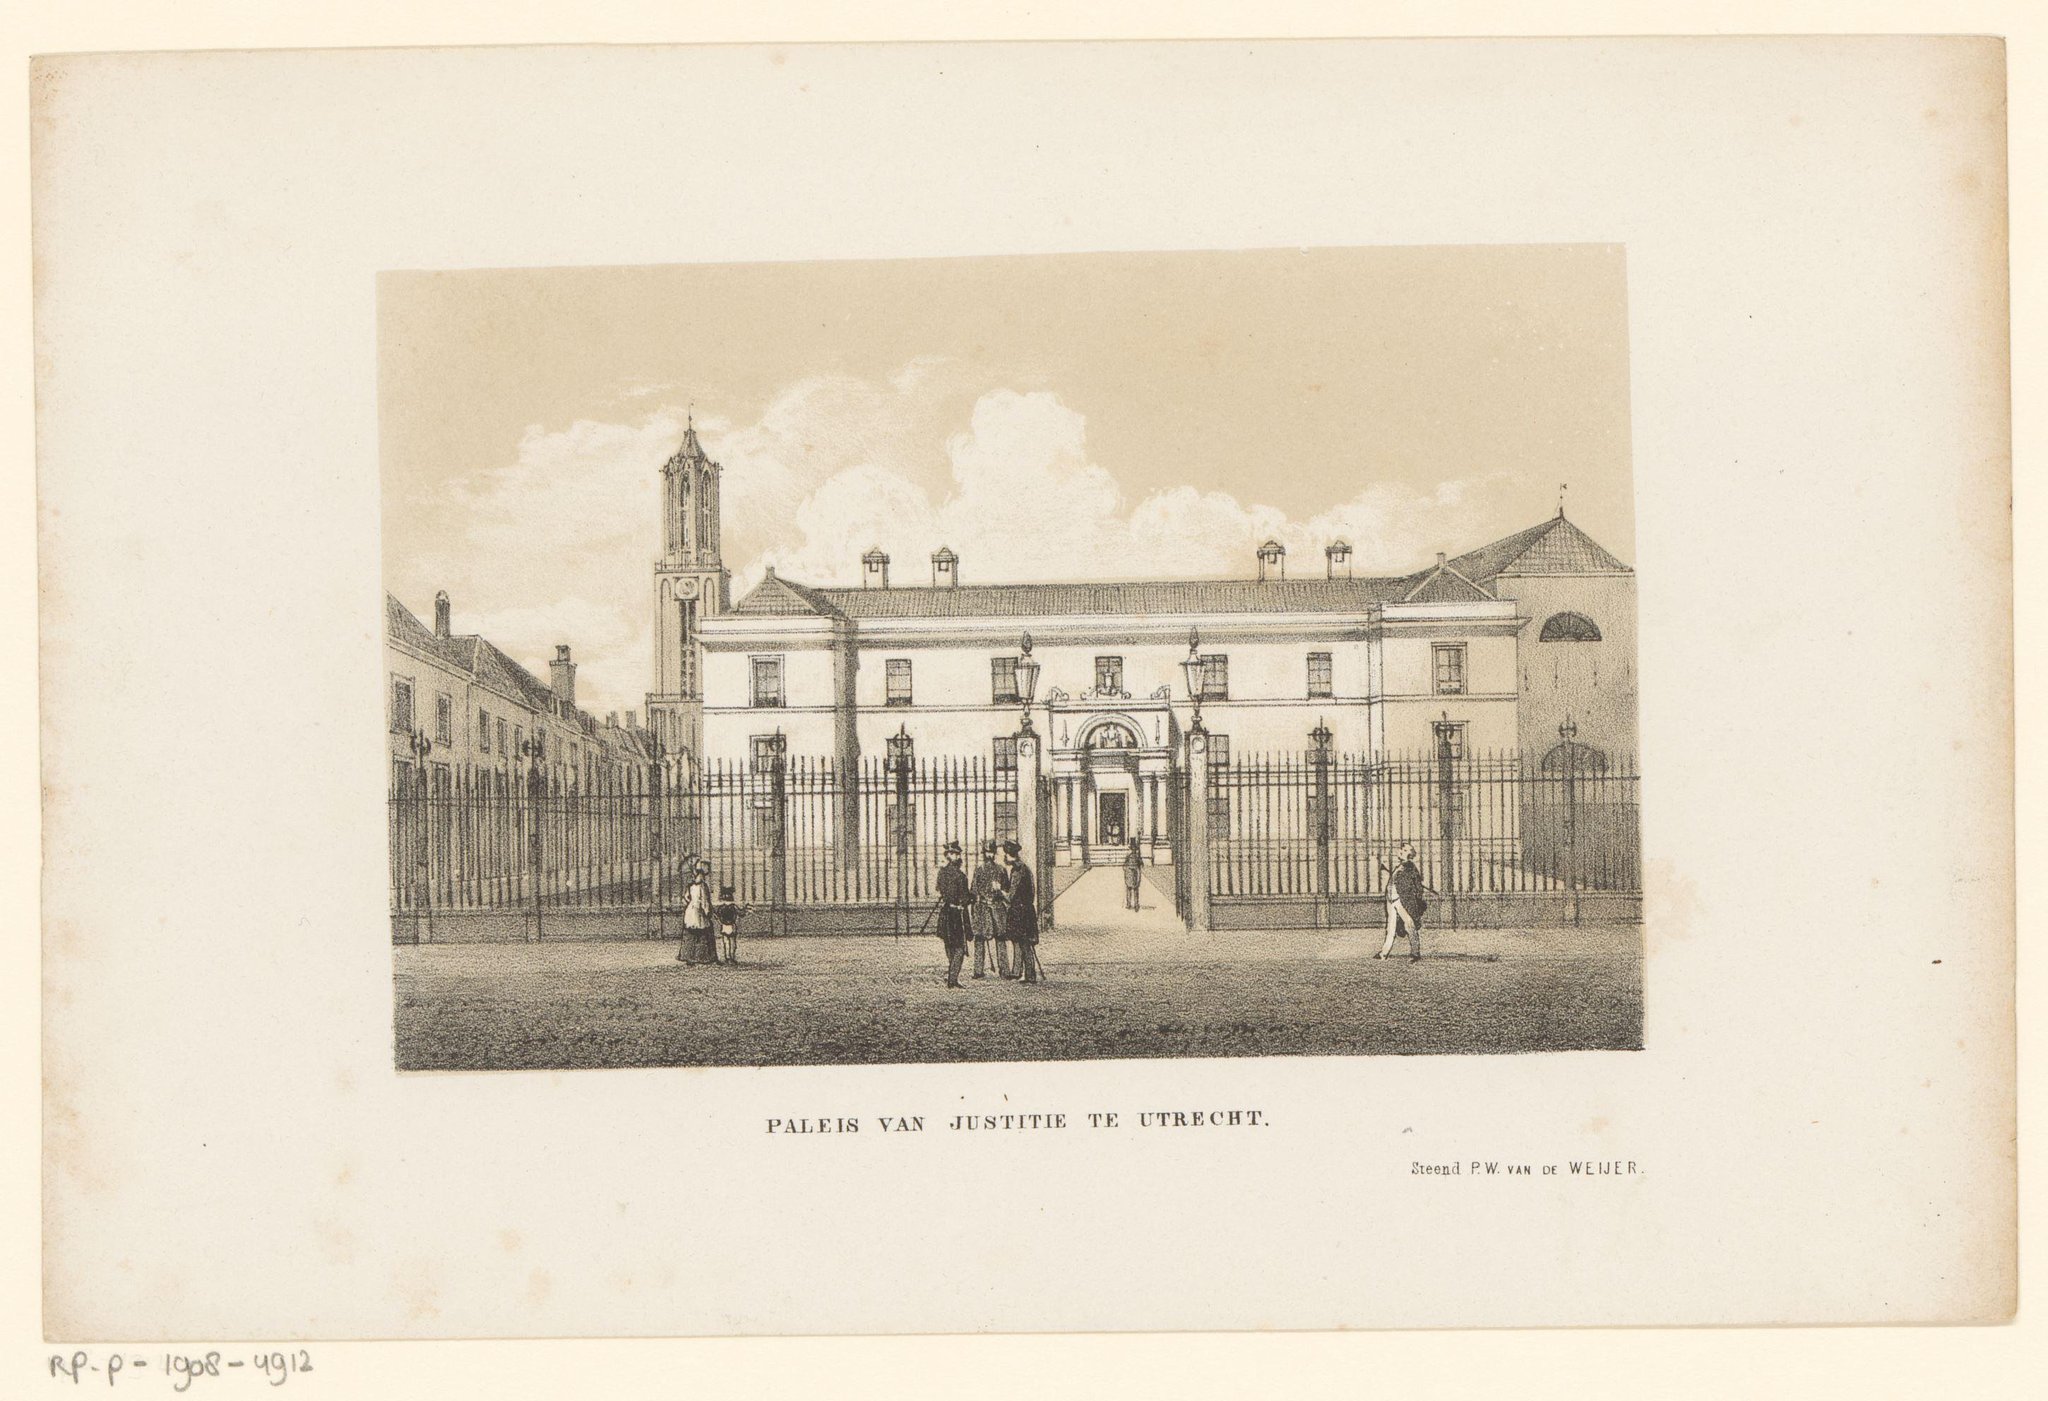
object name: print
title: Paleis van Justitie te Utrecht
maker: pieter wilhelmus van de weijer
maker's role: print maker, printer, publisher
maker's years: 1816-1880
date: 1856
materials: paper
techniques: tone lithography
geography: utrecht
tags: court building, city-view, and landscape with man-made constructions, utrecht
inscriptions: collector's mark: Lugt 2228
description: Het Paleis van Justitie aan de voorzijde. Links op de achtergrond de Domtoren rechts de St. Paulus abdij.